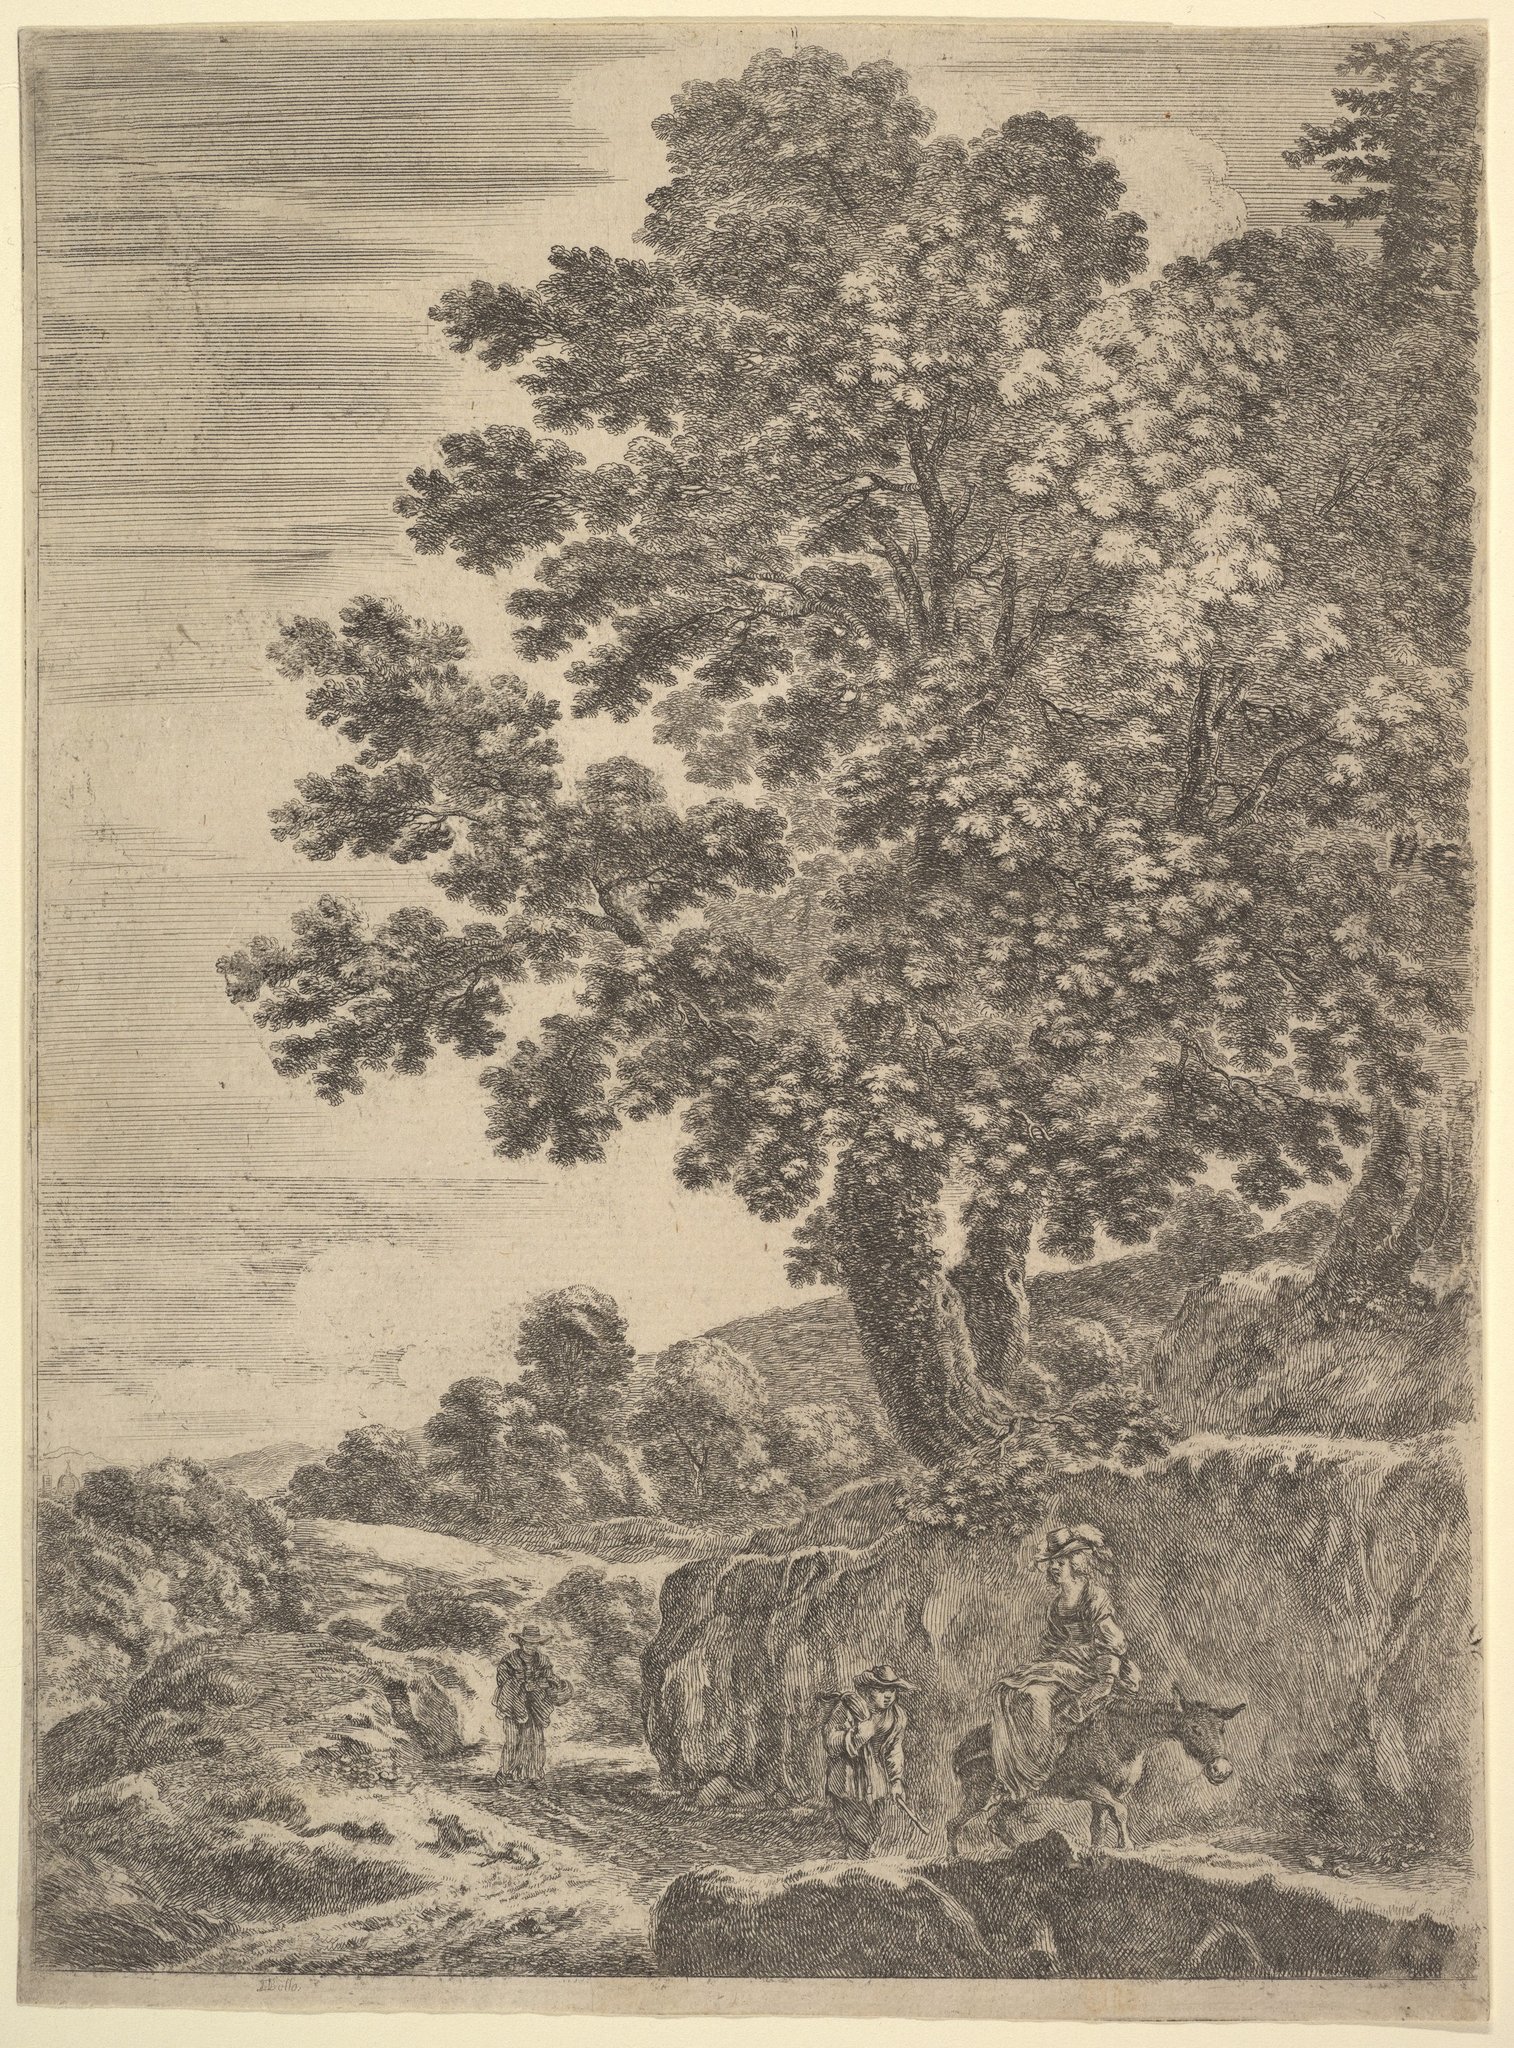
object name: print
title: A young woman seated on a donkey wearing a hat, two men follow to left, a large tree above to right, from "Four large landscapes" (Quatre grands paysages en hauteur)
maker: stefano della bella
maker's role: artist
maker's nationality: italian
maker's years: 1610-1664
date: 1652-1657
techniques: etching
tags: women,donkeys,landscapes